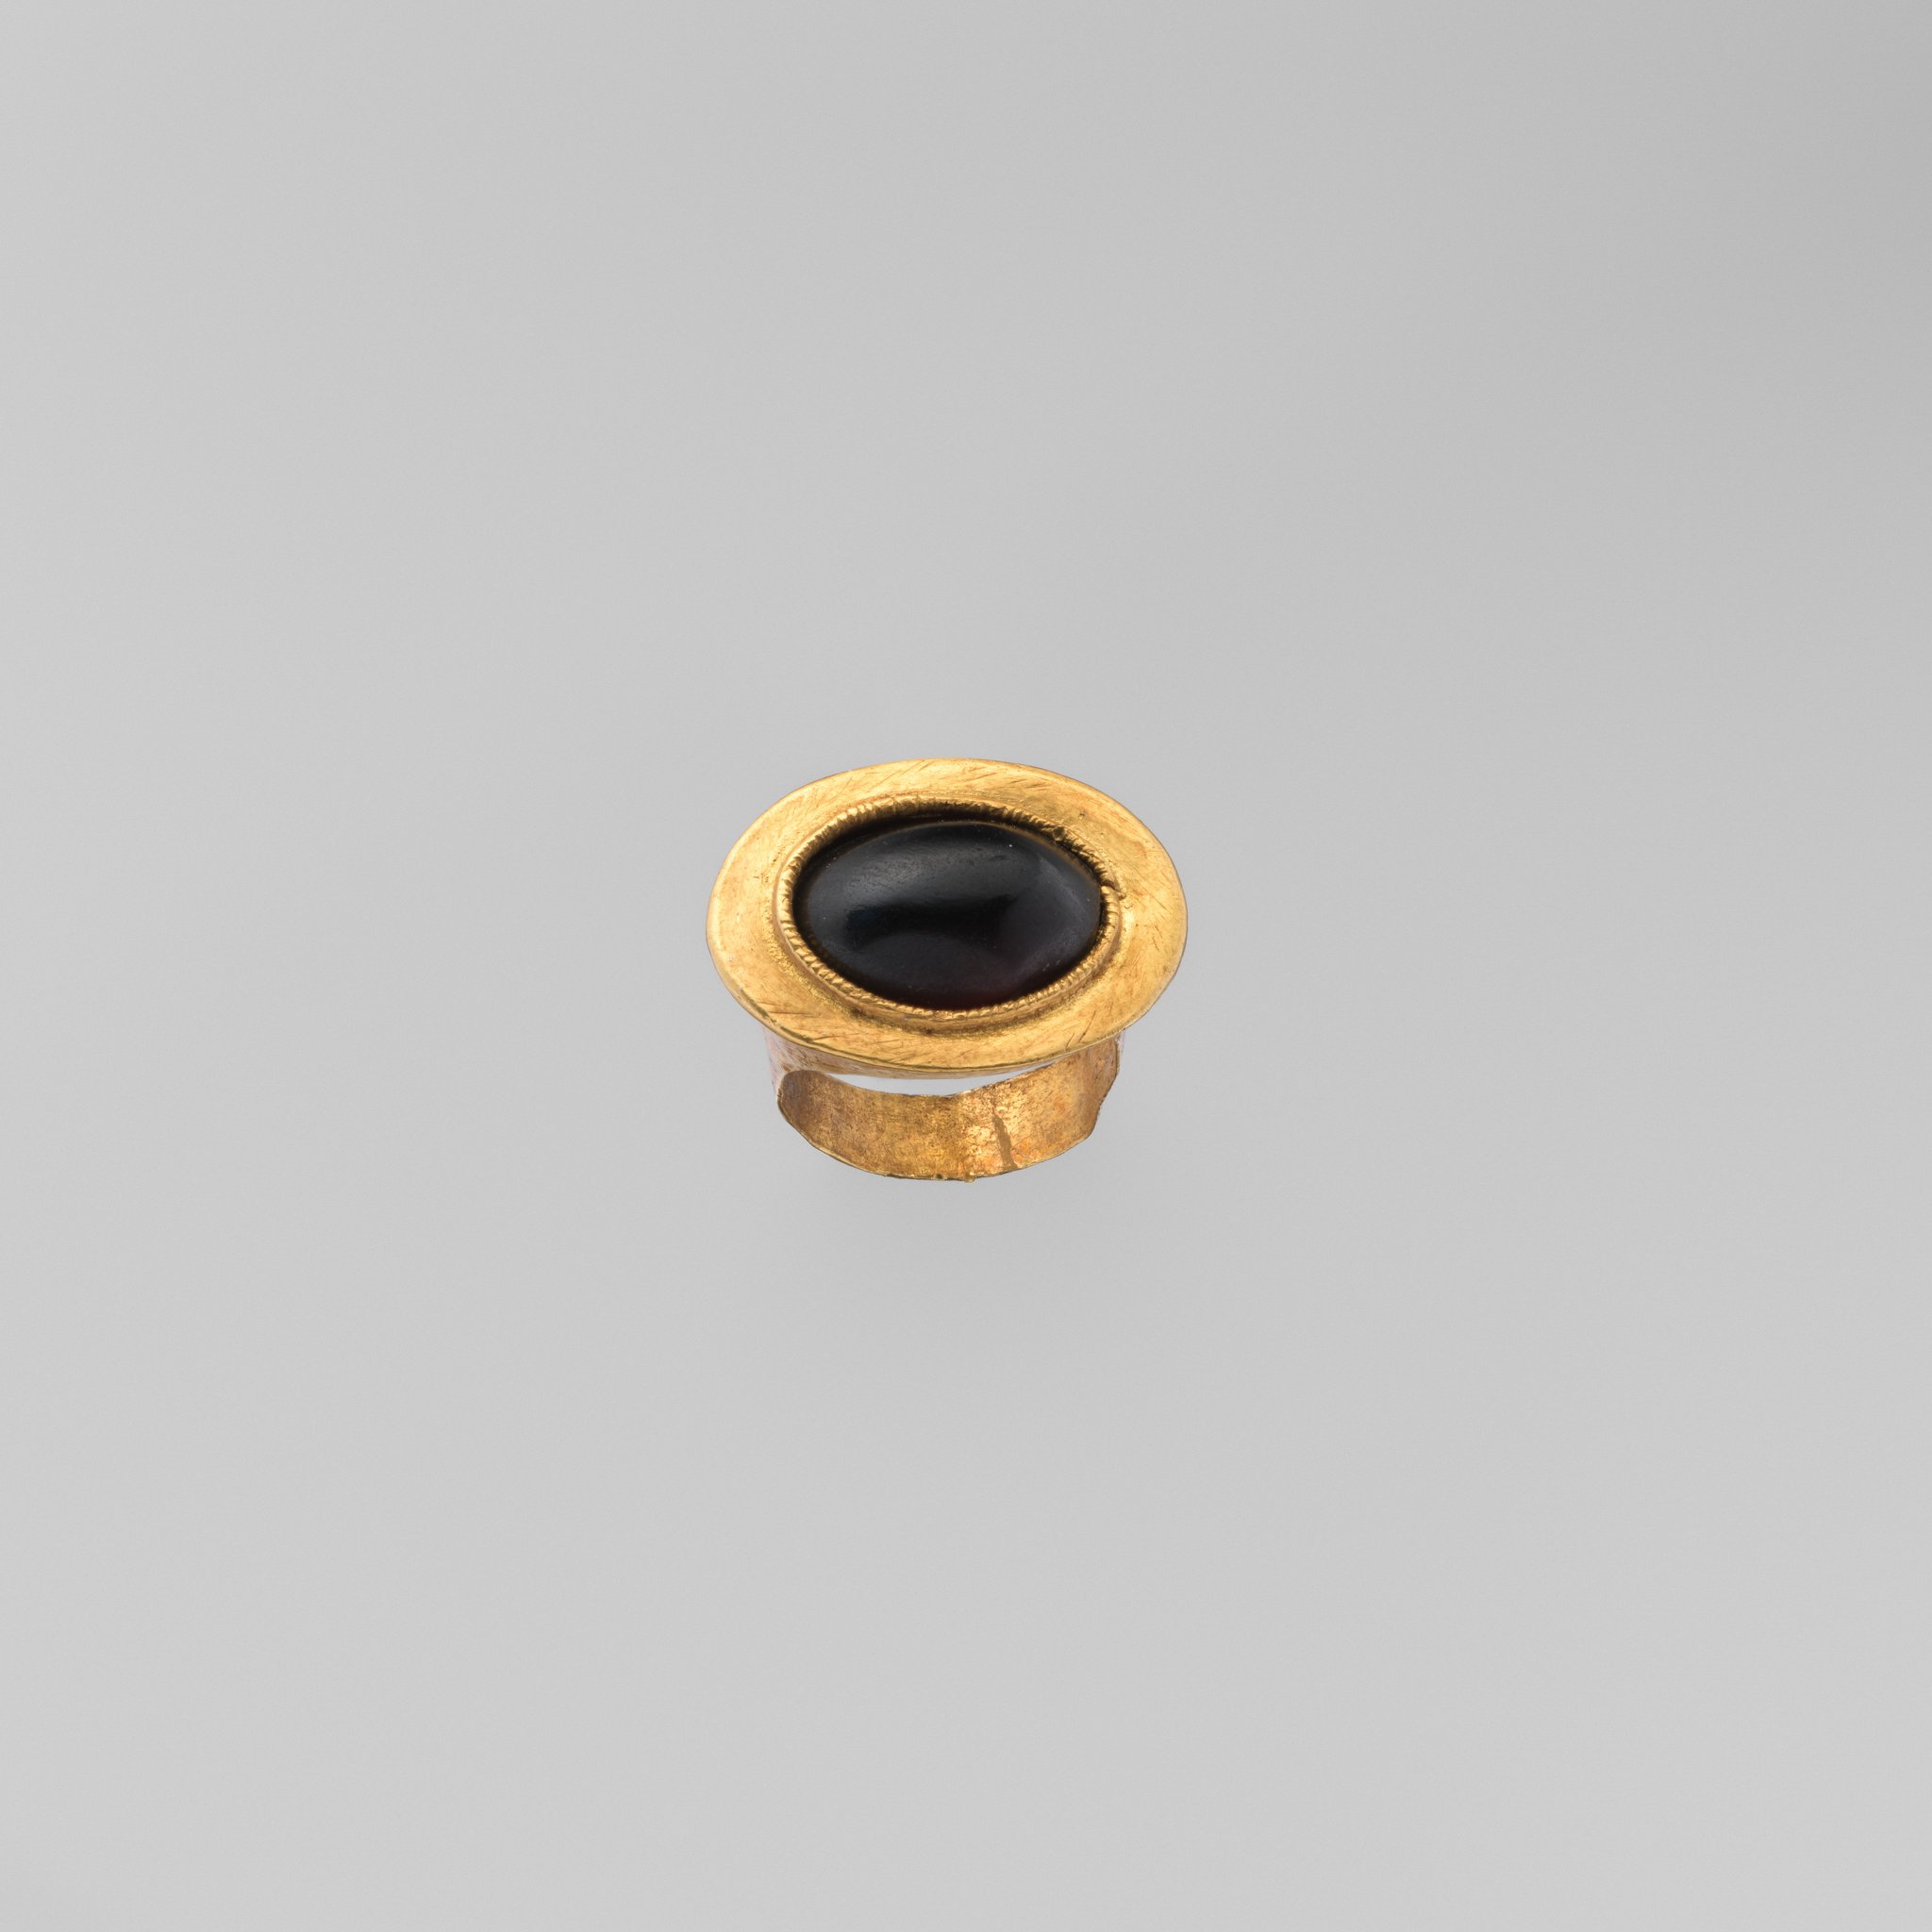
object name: ring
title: Gold and garnet ring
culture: roman, cypriot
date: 100 BCE-100 CE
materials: gemstone, gold